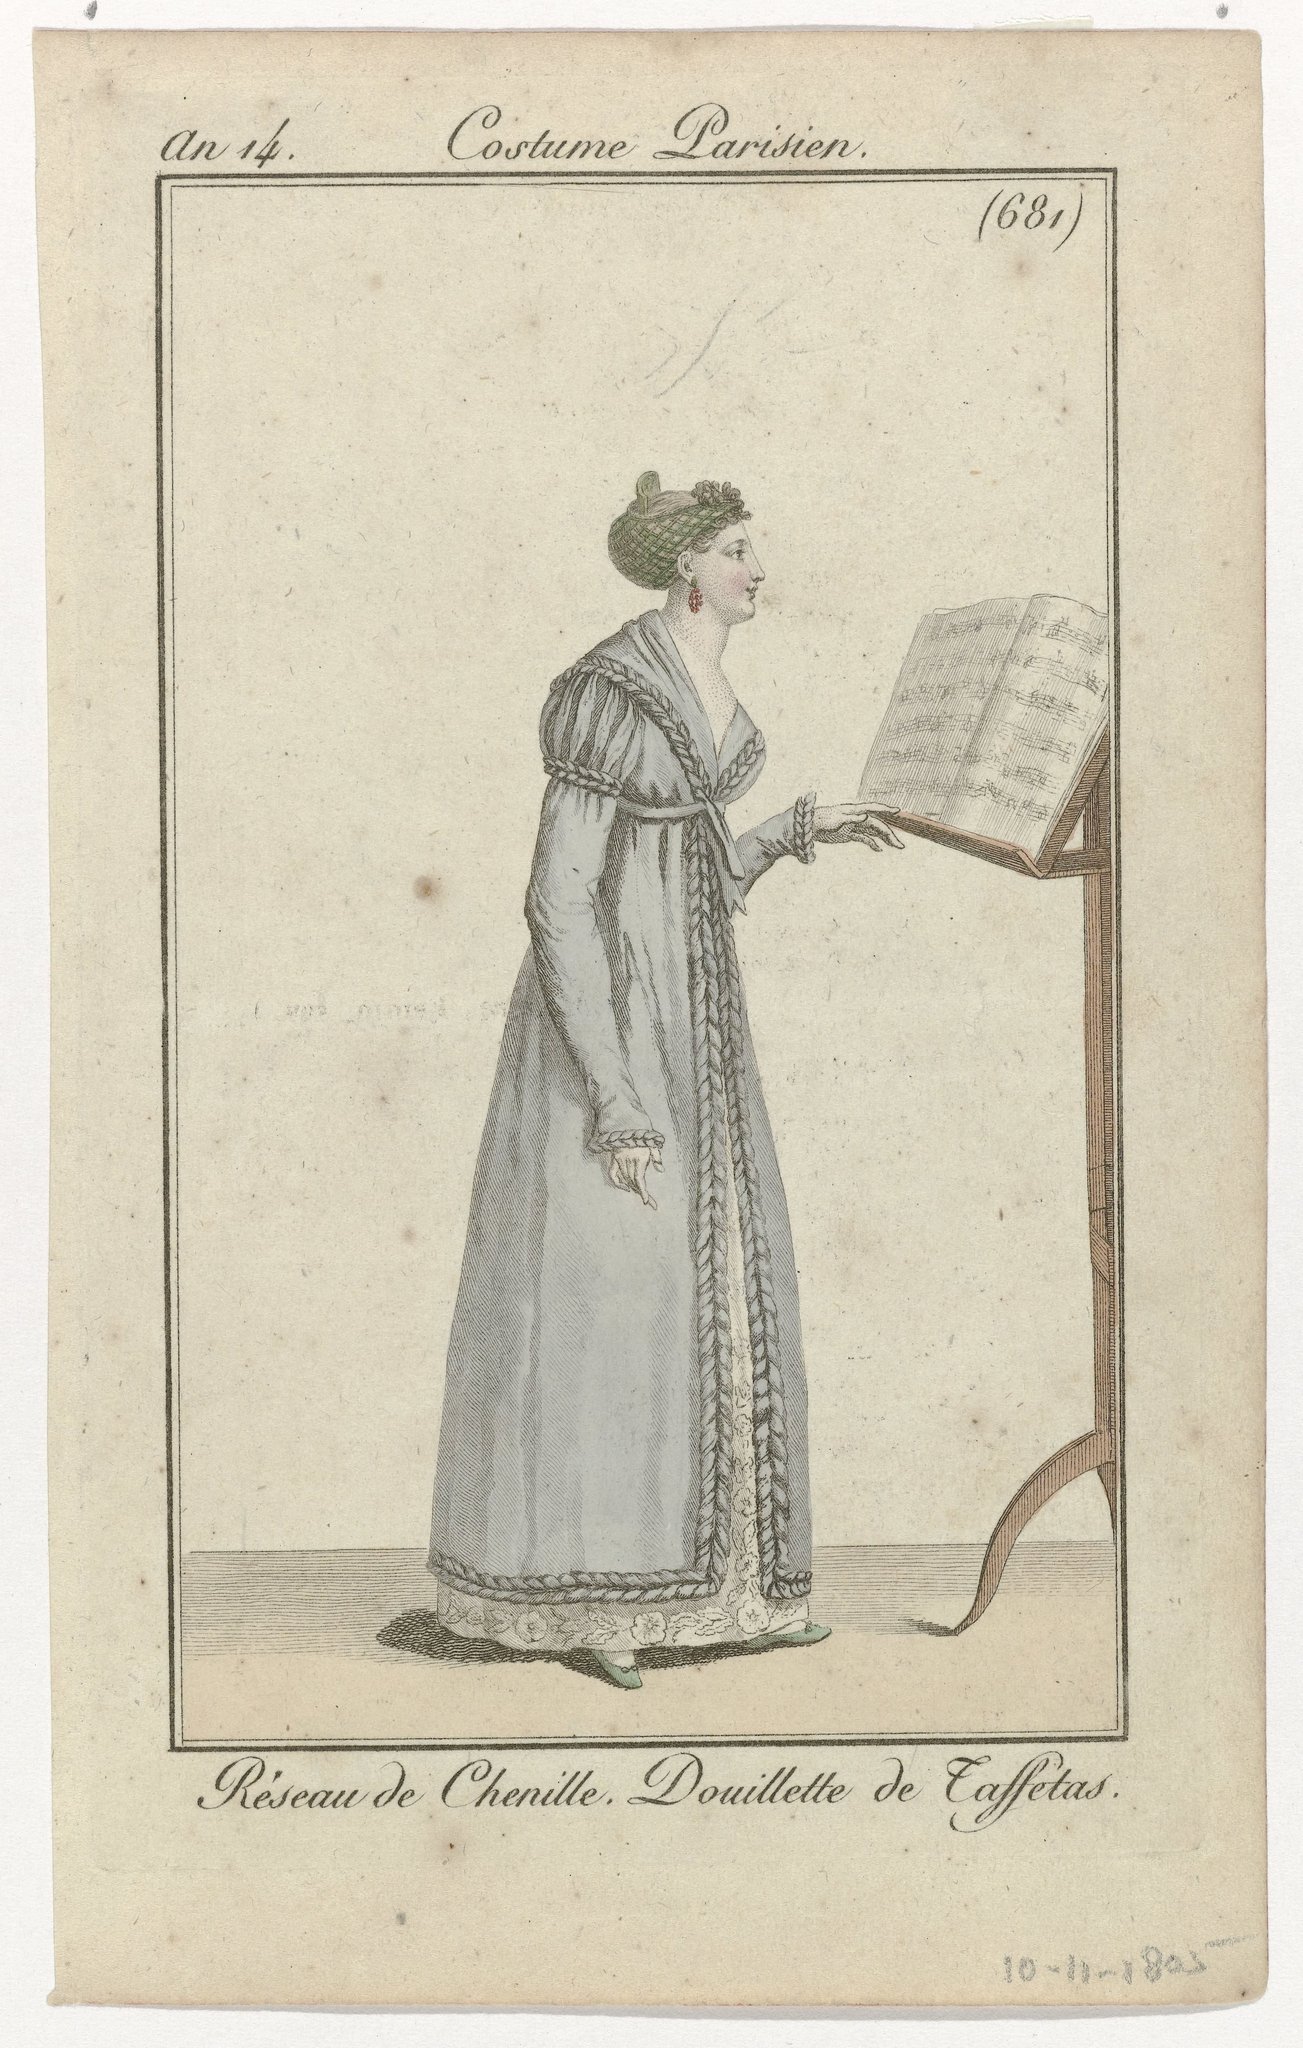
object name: fashion print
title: Journal des Dames et des Modes, Costume Parisien, 16 novembre 1805, An 14, (681): Réseau de Chenill (...)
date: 1805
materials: paper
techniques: engraving, hand coloring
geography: paris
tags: ear-rings (+ women's clothes), notation of music, head-gear (+ women's clothes), fashion plates, shoes, sandals (+ women's clothes), skirt (+ women's clothes)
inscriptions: title: ‘Costume Parisien.’, caption: ‘Réseau de Chenille. Douillette de Taffetas.’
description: Vrouw, staande bij een lessenaar met bladmuziek, met een haarnet van chenille in het haar. Zij draagt een 'douillette' van tafzijde op een rok met bloem- en bladmotief. Oorbel in het rechteroor. platte schoenen met strikken. De prent maakt deel uit van het modetijdschrift Journal des Dames et des Modes, uitgegeven door Pierre de la Mésangère, Parijs, 1797-1839.